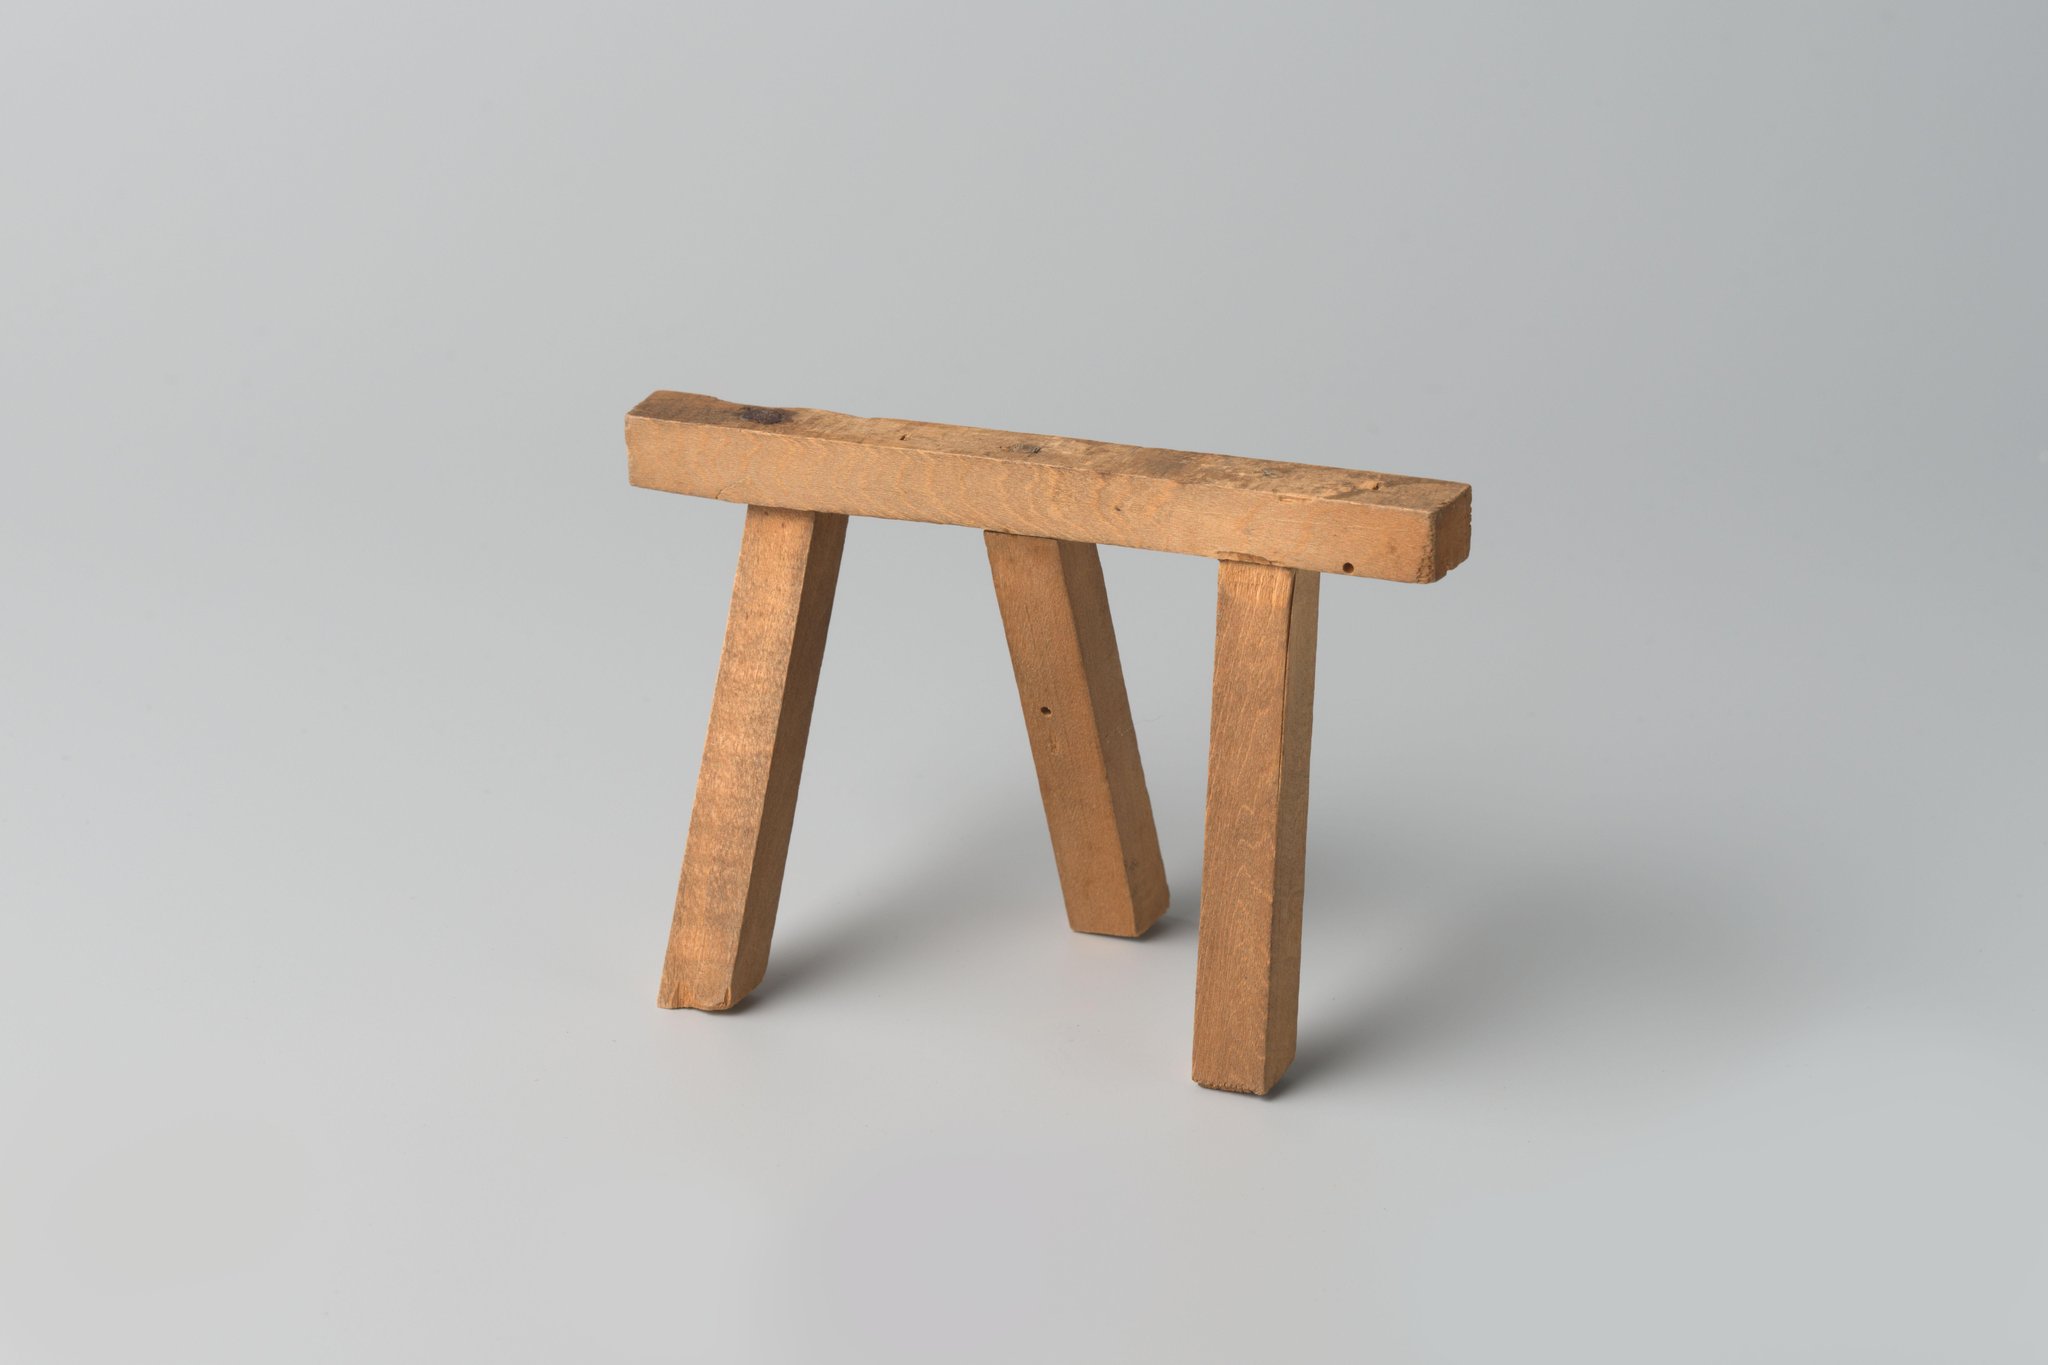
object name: trestle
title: Schraag van without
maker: Anonymous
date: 1676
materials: without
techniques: without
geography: amsterdam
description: Schraag vervaardigd van without, bestaande uit een horizontale balk en drie schuinstaande poten gemaakt van without, door metalen nagels verbonden.